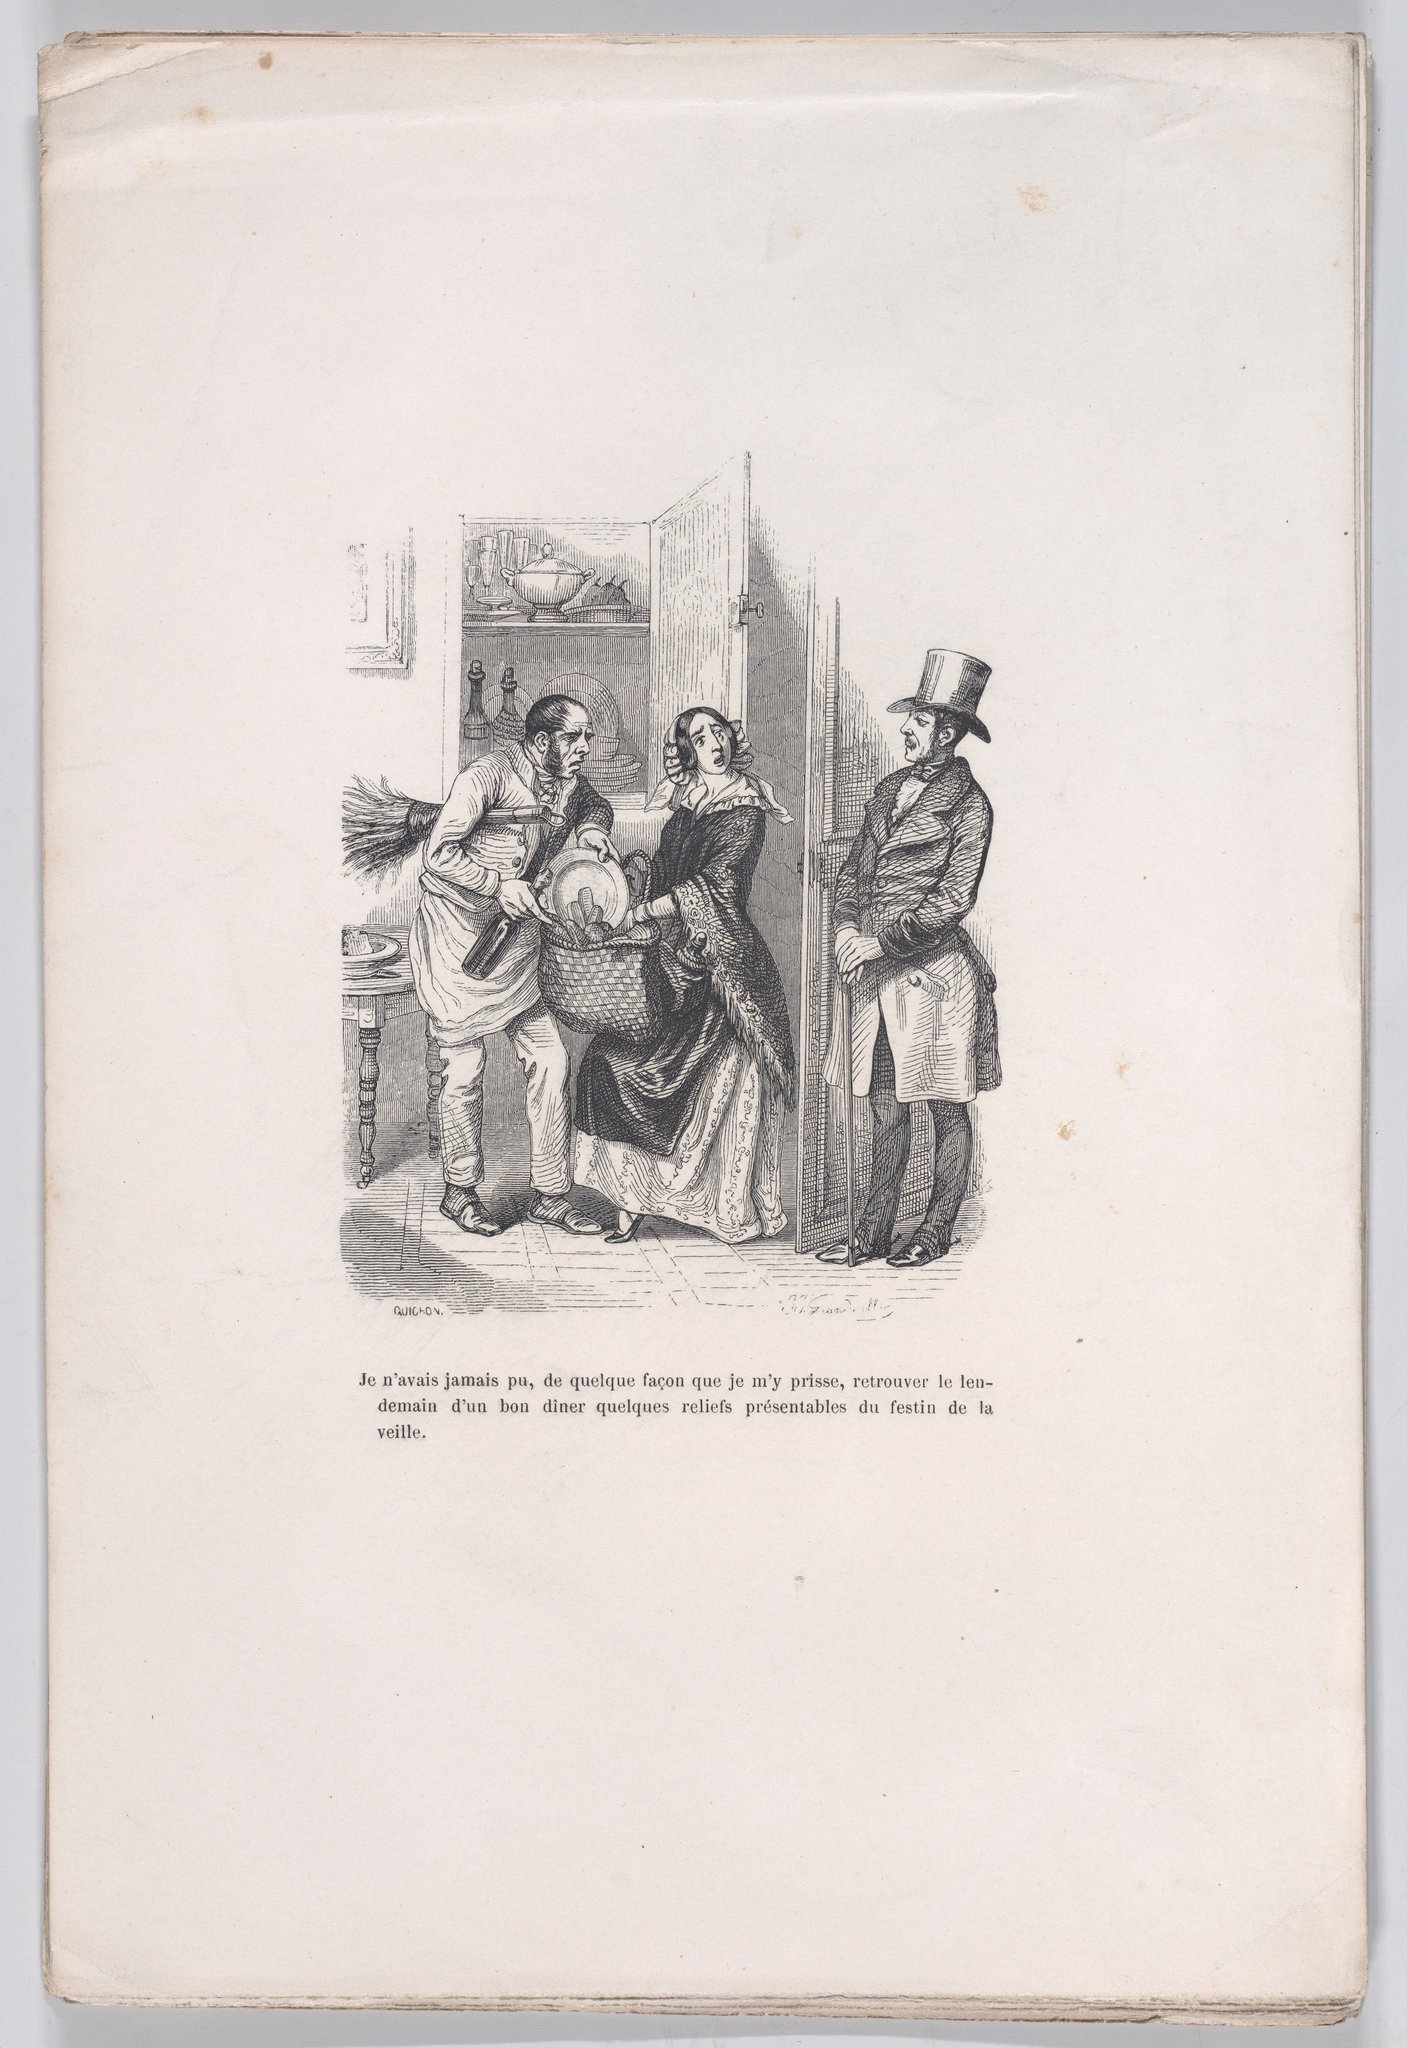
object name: print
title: Leftovers, from "Little Miseries of Human Life"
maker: j. j. grandville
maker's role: illustrator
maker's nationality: french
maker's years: 1803-1847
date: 1843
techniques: engraving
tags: men,women